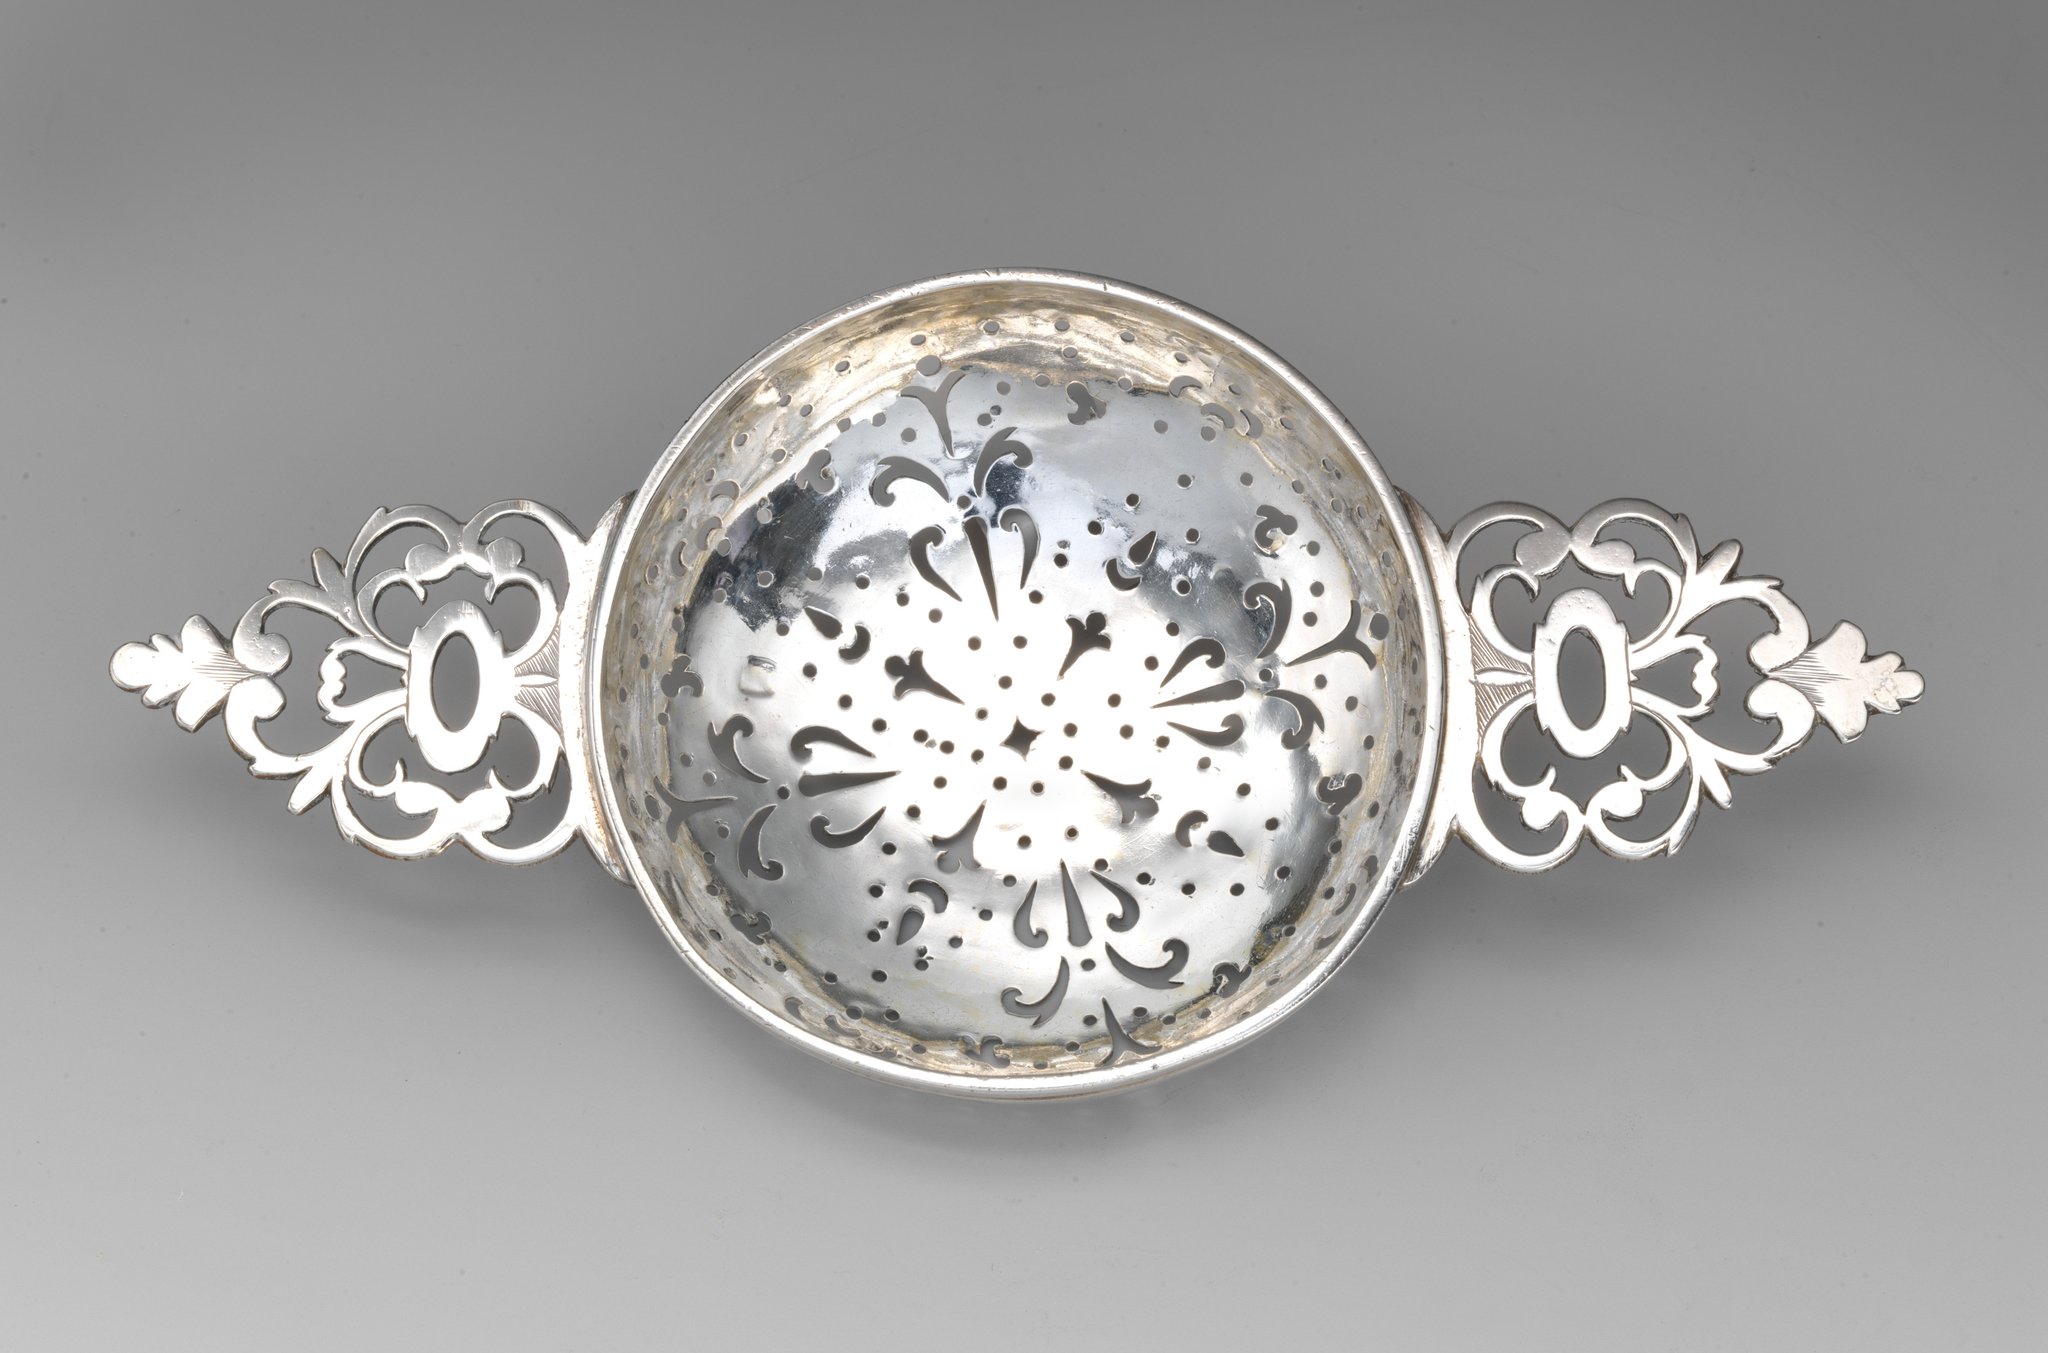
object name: orange strainer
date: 1722-1723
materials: silver